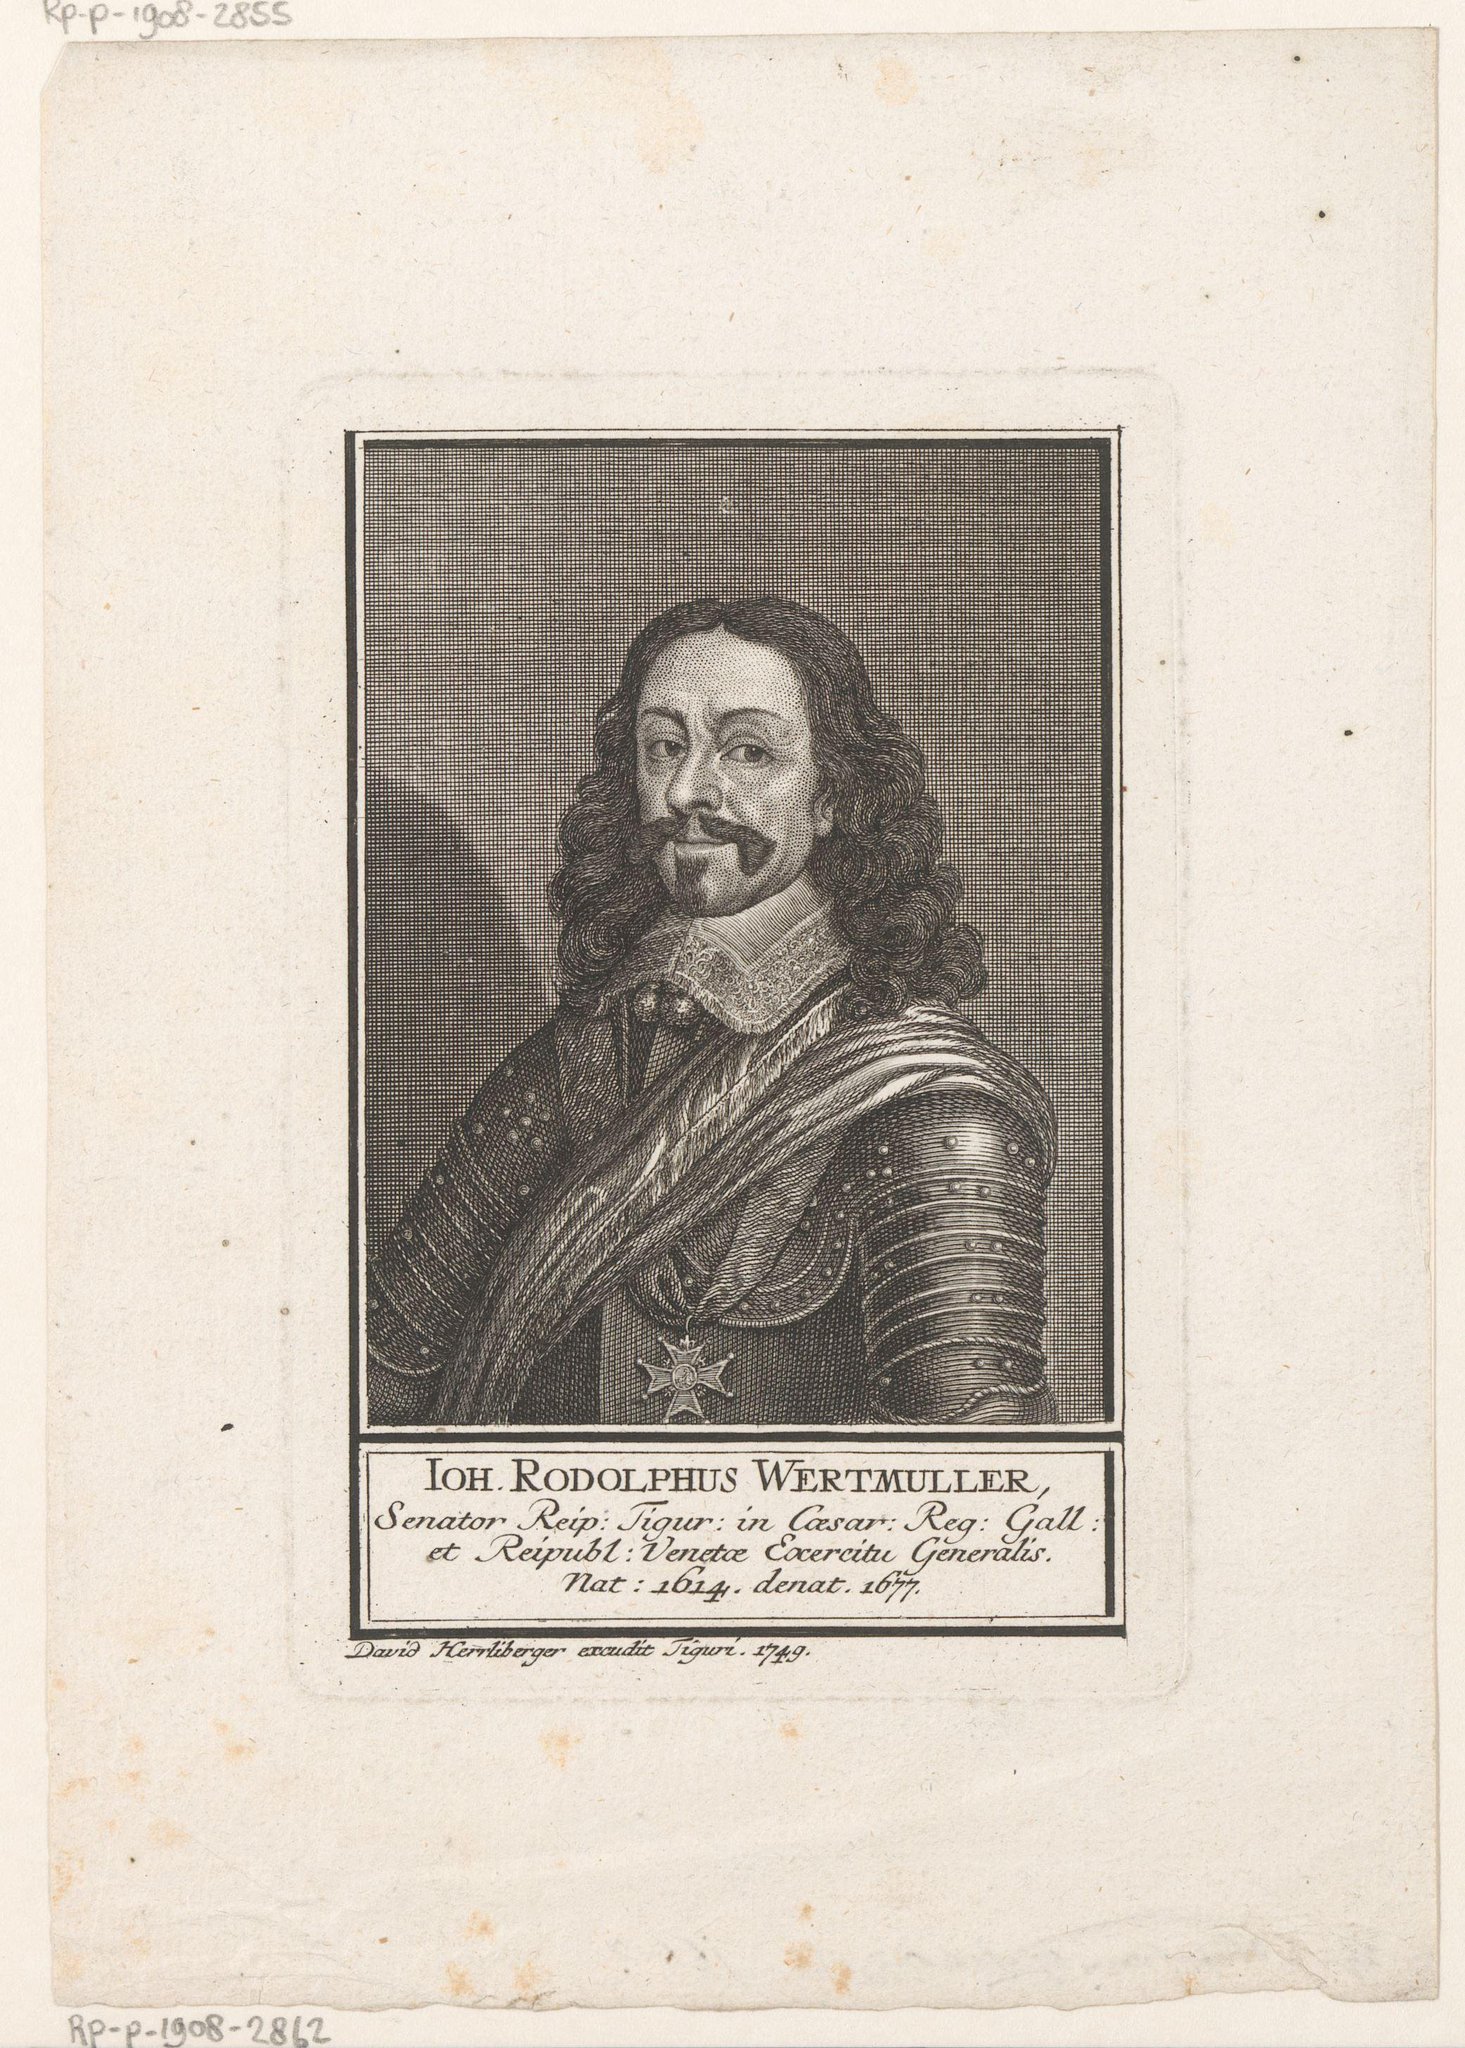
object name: print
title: Portret van Johann Rudolf Werdmüller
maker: david herrliberger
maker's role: print maker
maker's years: 1697-1777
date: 1749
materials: paper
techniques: engraving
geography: zurich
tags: armour, historical persons, medals and other marks of military honour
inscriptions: collector's mark: Lugt 2228